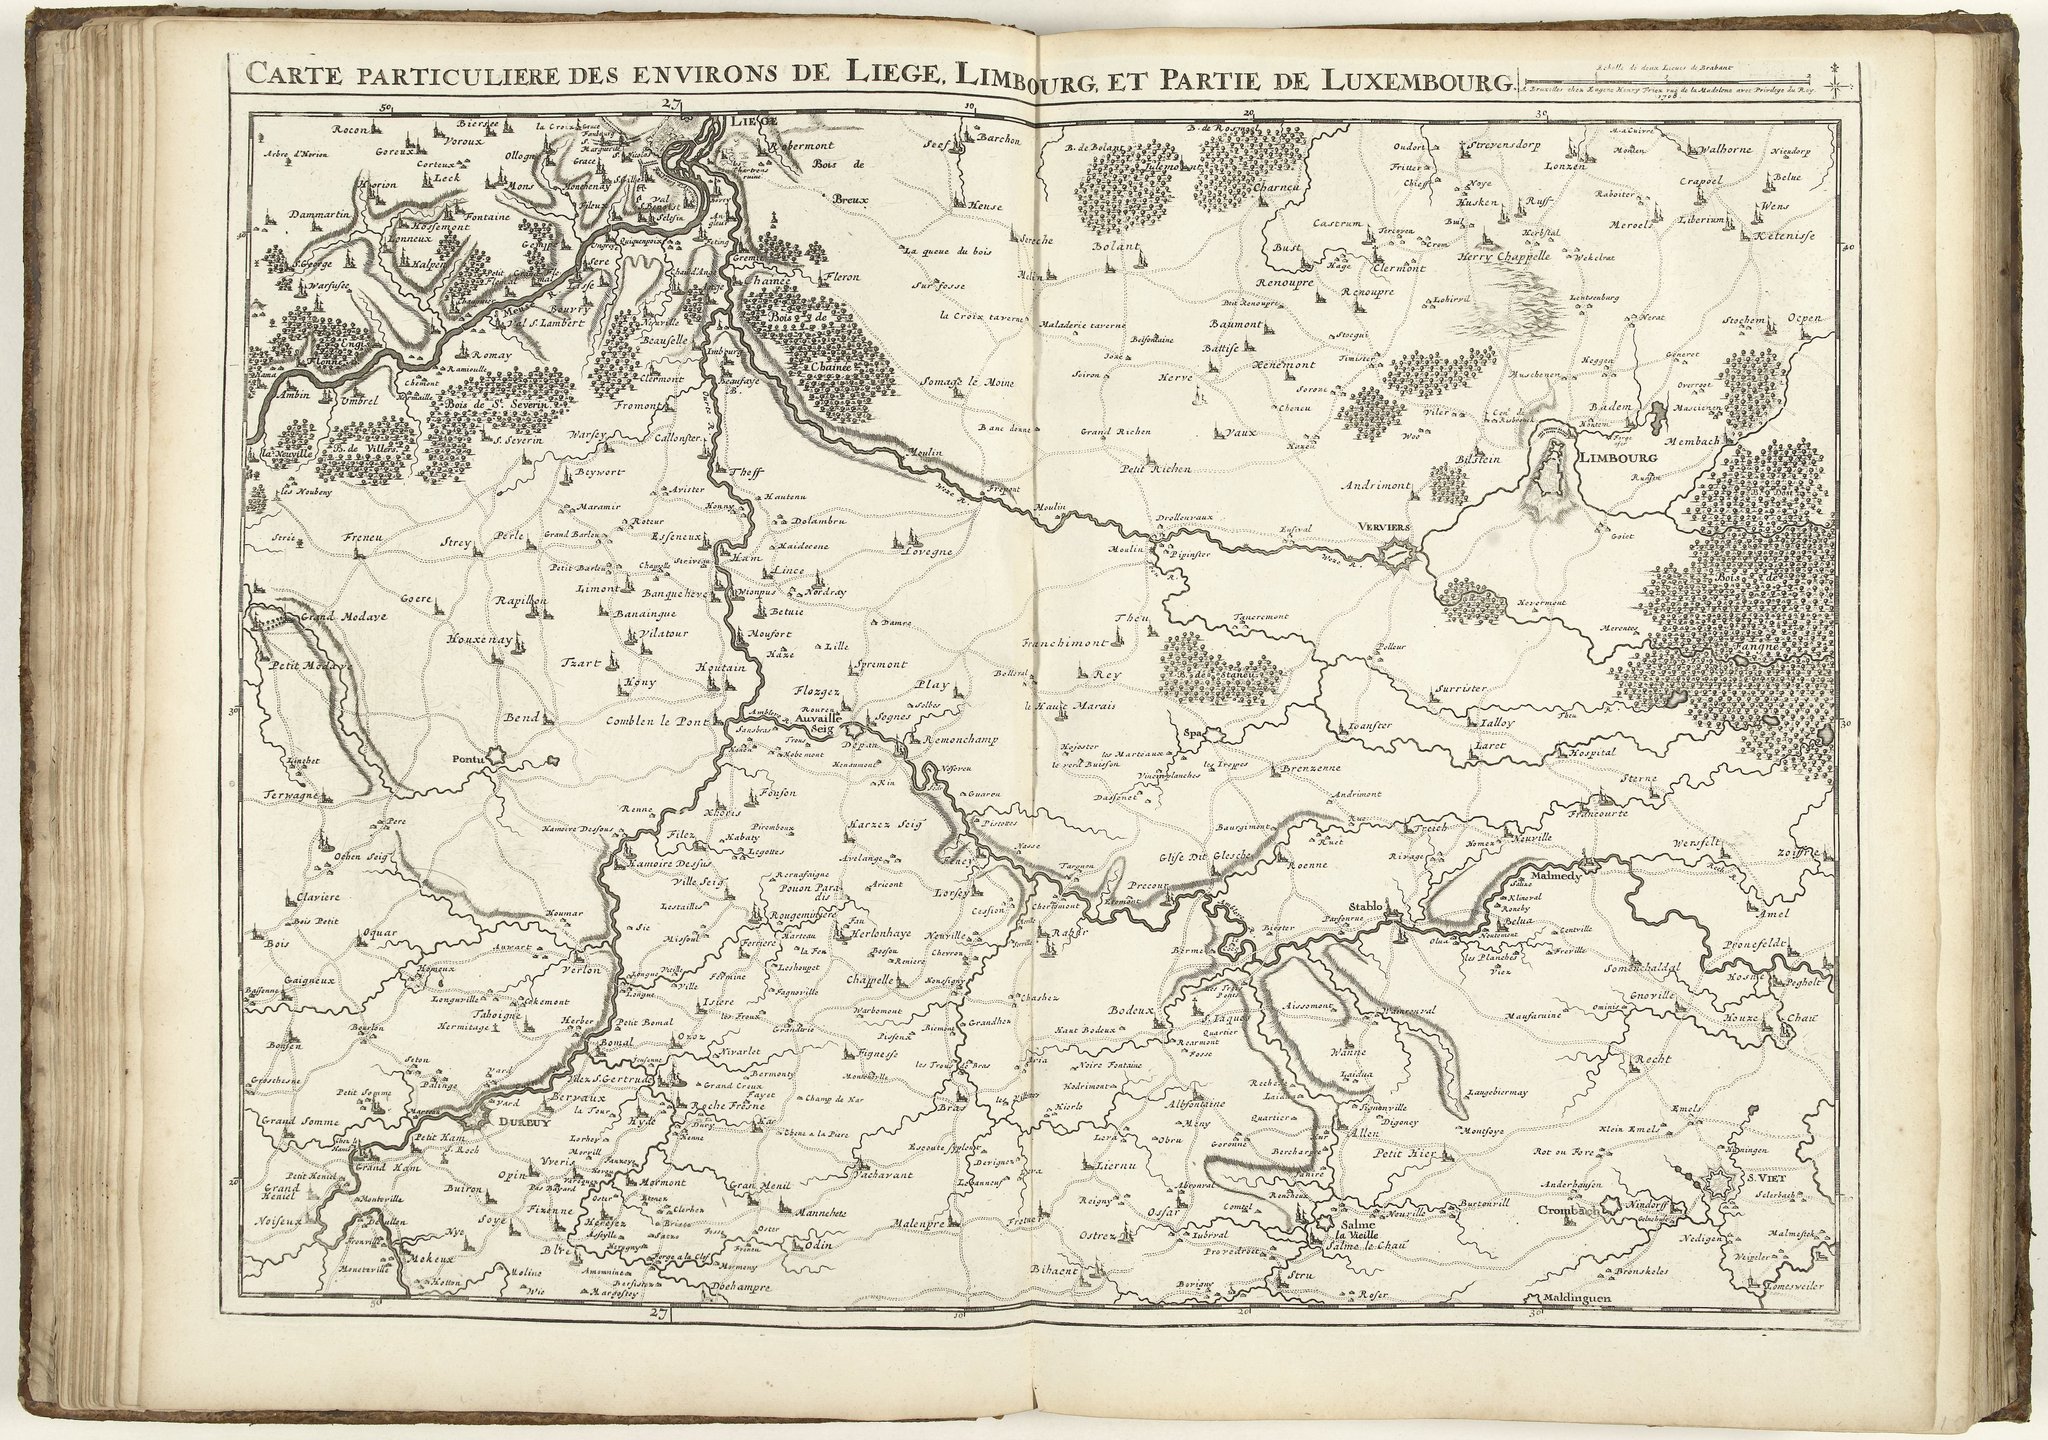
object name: map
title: Carte particuliere des environs de Liege, Limbourg, et partie de Luxembourg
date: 1708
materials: paper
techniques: engraving, etching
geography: brussels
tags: maps of separate countries or regions, liège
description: Kaart van de provincies Luik en Luxemburg, 1708. Onderdeel van een gebundelde verzameling van plannen van veldslagen en steden vermaard in de Spaanse Successieoorlog. Deze plaat behoort tot de eerste 24 platen die samen een zeer grote kaart van de Zuidelijke Nederlanden vormen.